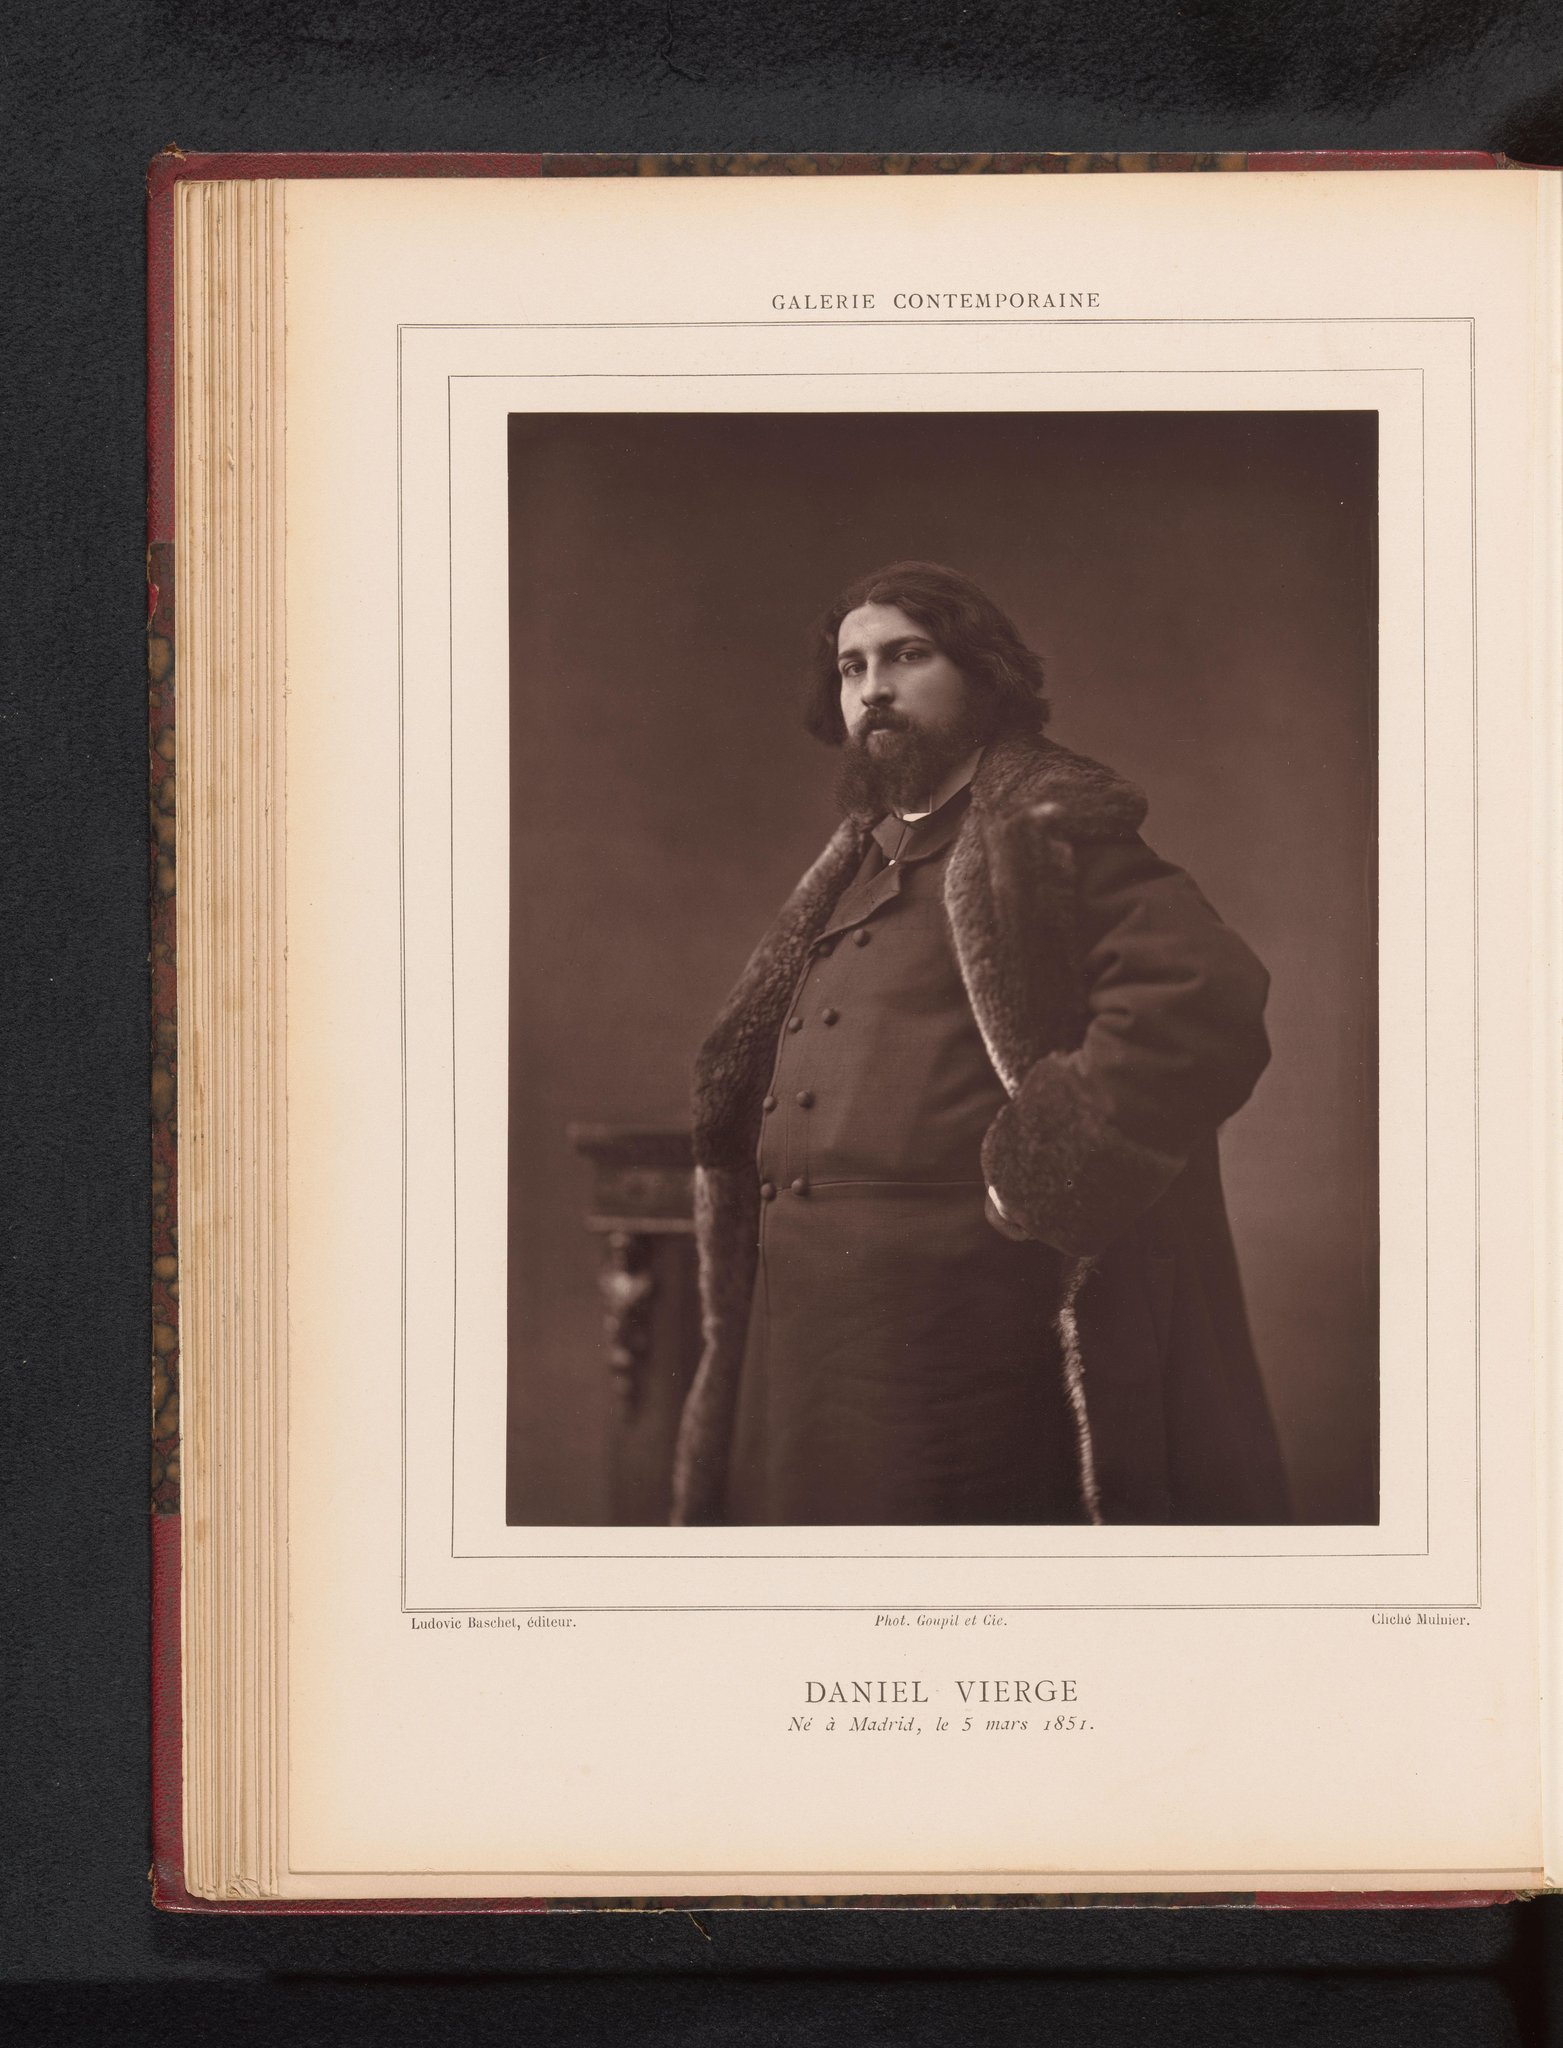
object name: page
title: Portret van Daniel Urrabieta Vierge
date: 1867-1880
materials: paper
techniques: woodburytype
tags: painter, print maker, draughtsman, daniel urrabieta vierge, adult man, historical persons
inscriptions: inscription: ‘Galerie Contemporaine/ Ludovic Baschet, éditeur./ Né a Madrid, le 5 mars 1851.’